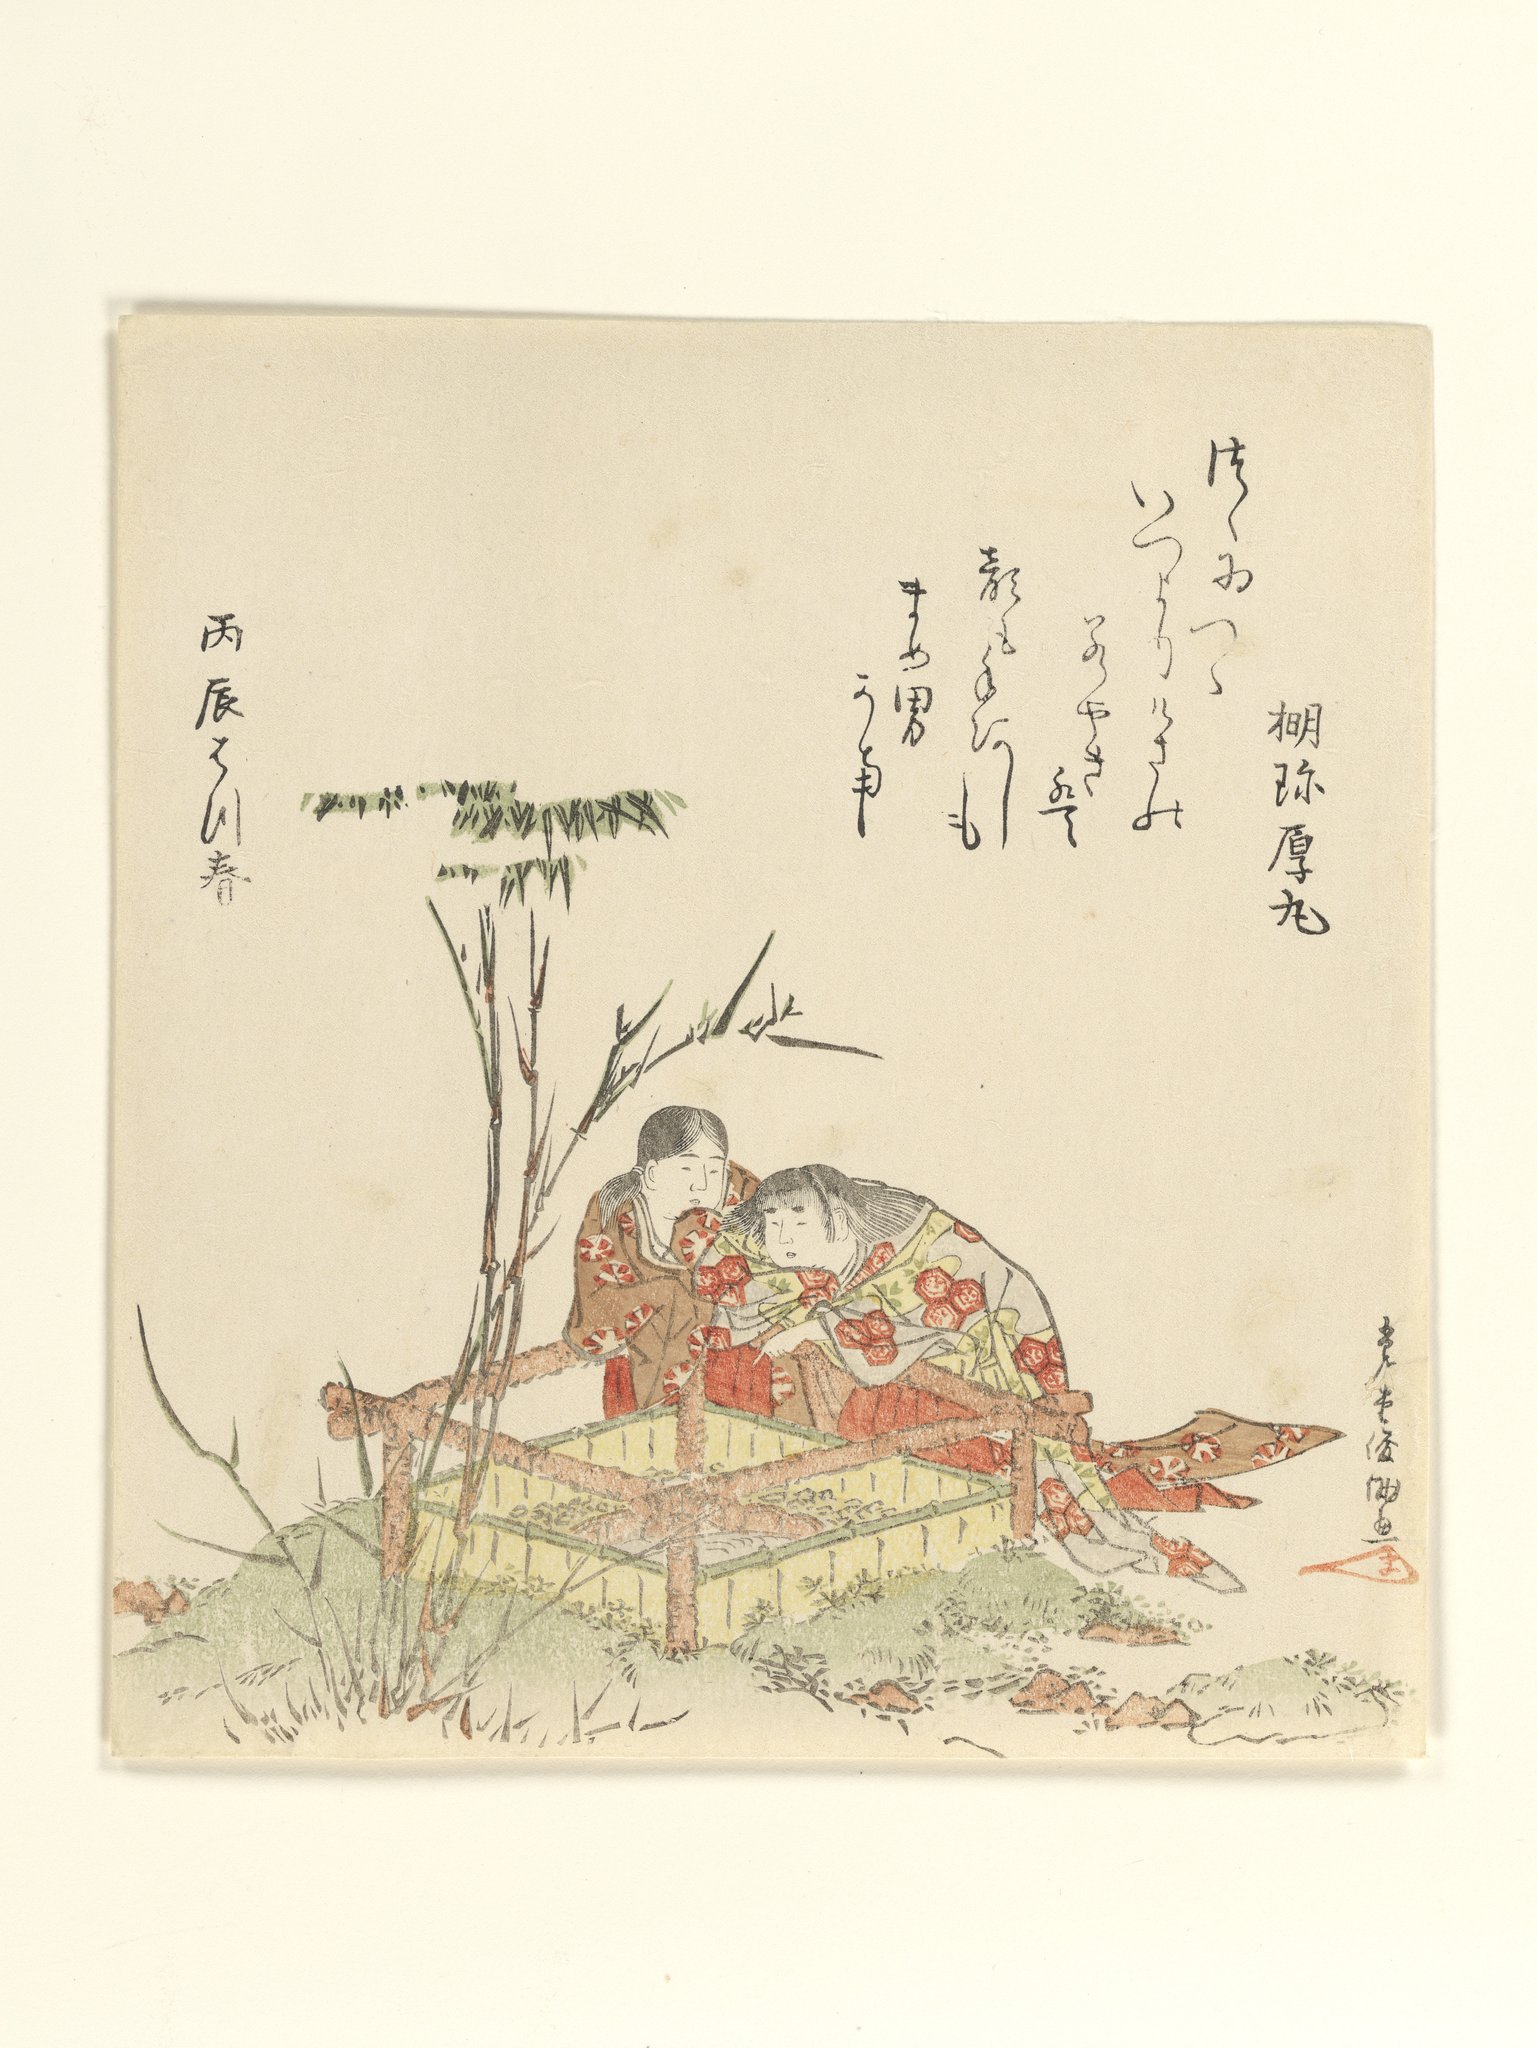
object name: print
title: Two Children by a Well Curb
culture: japanese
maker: kubo shunman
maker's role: artist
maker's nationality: japanese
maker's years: 1757-1820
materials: ink, paper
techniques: surimono, woodblock print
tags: wells,children